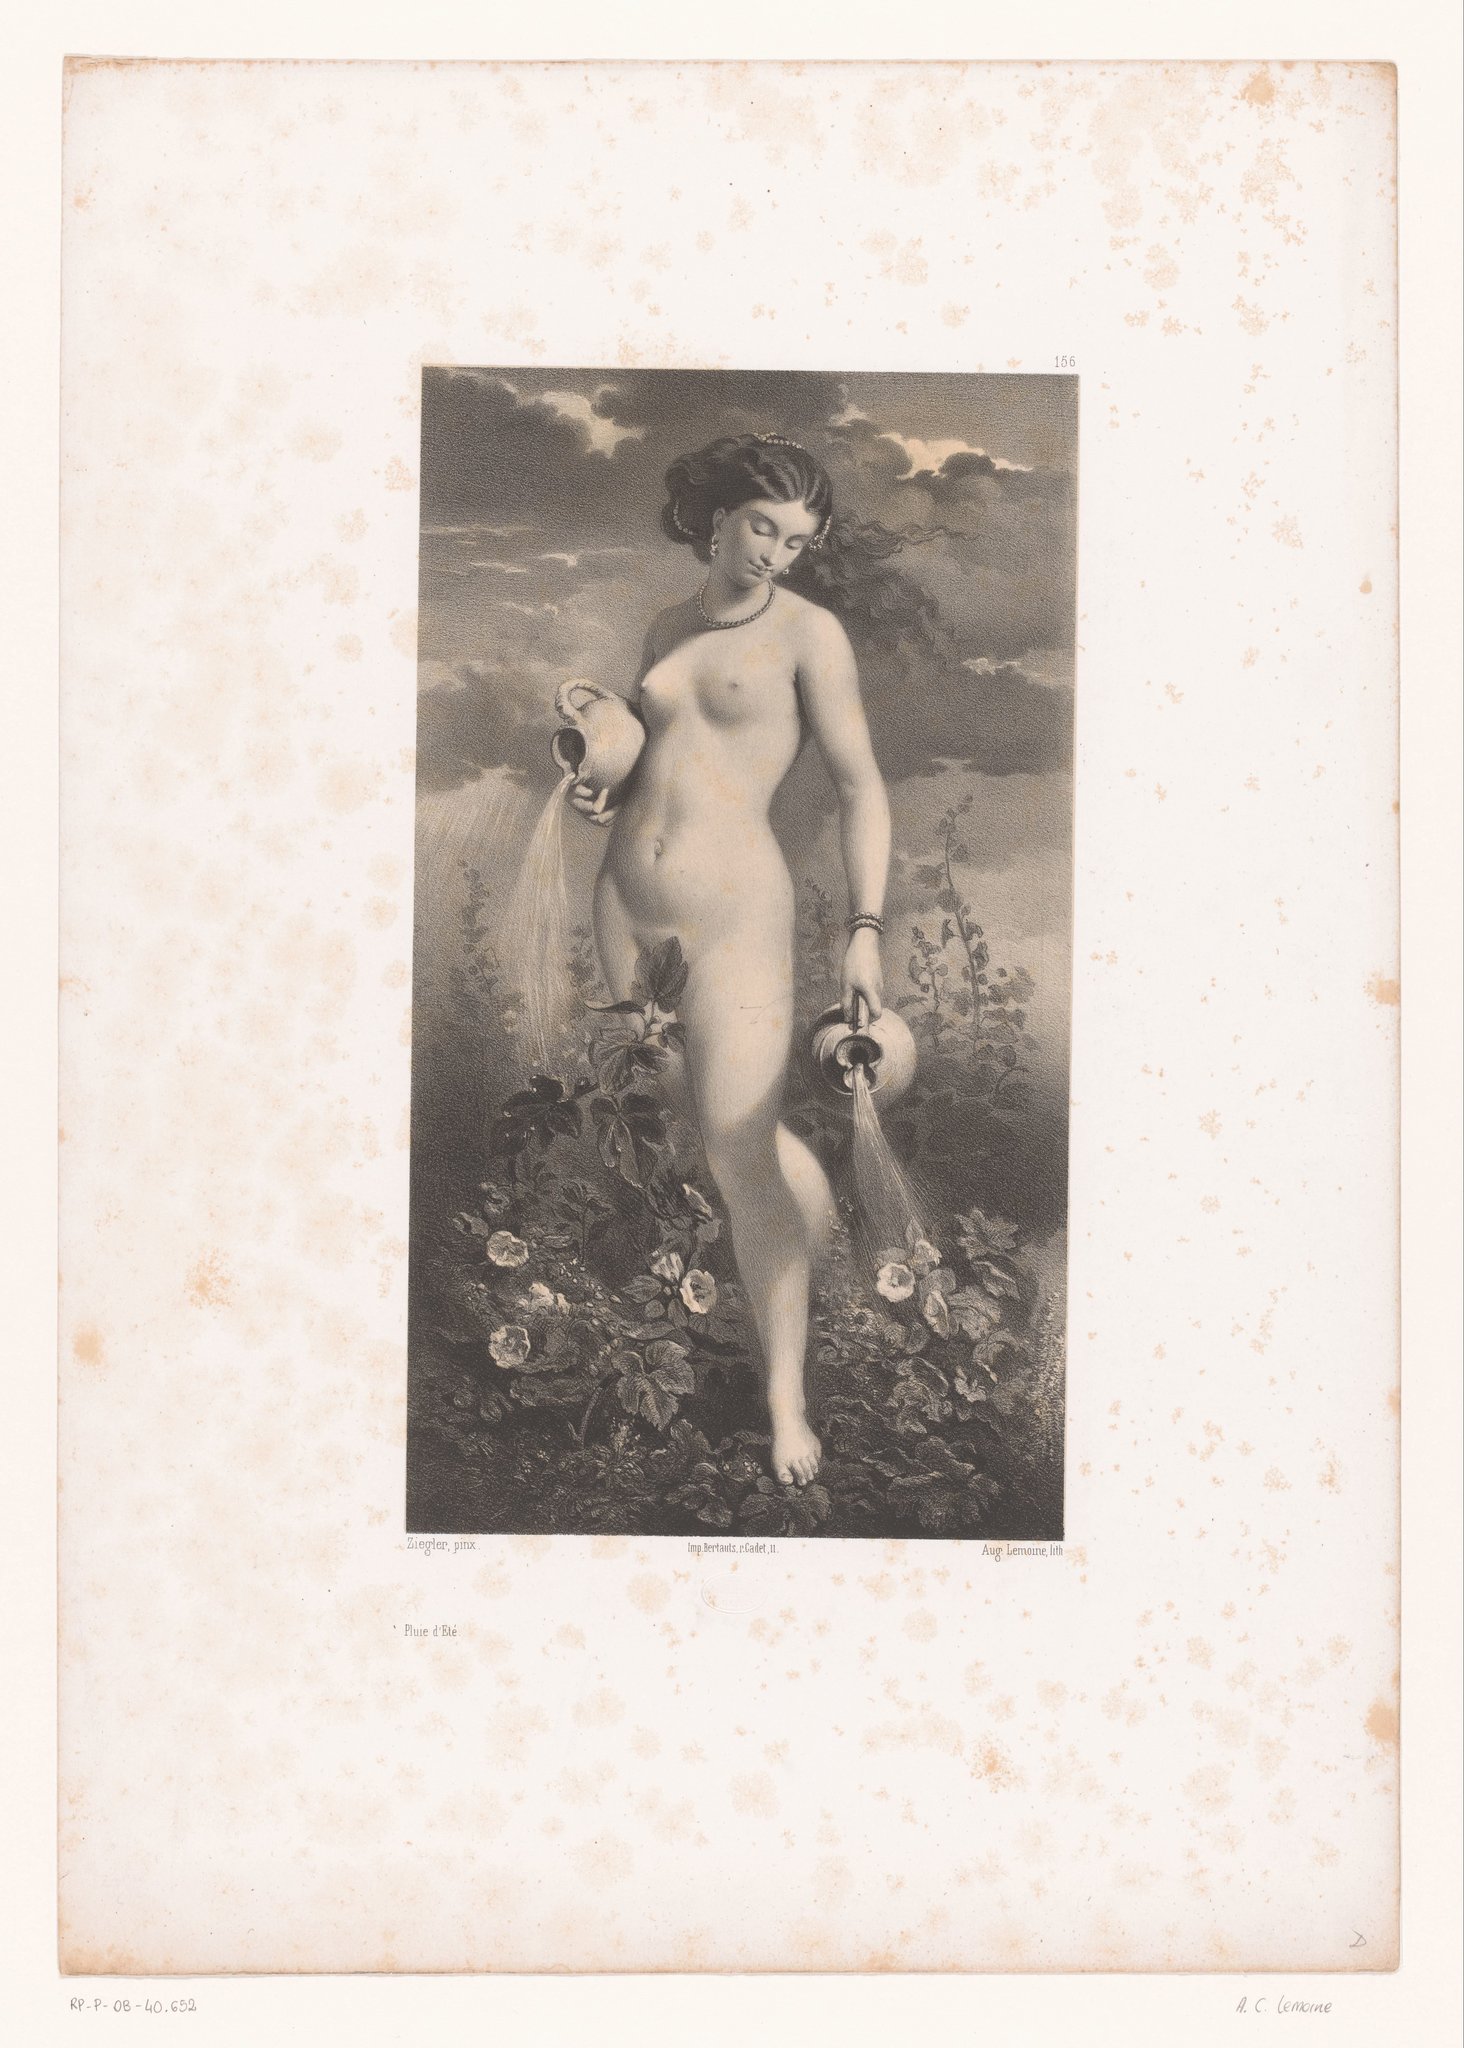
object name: print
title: Naakte vrouw geeft bloemen water met twee kruiken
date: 1851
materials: paper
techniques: lithograph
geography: paris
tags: flowers, woman (showing herself) undressed, quasi-nude, watering plants, container of ceramics: jar, jug, pot, vase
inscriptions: check stamp: Lugt 36a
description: Prent gebruikt voor: Les Artistes Anciens et Modernes.